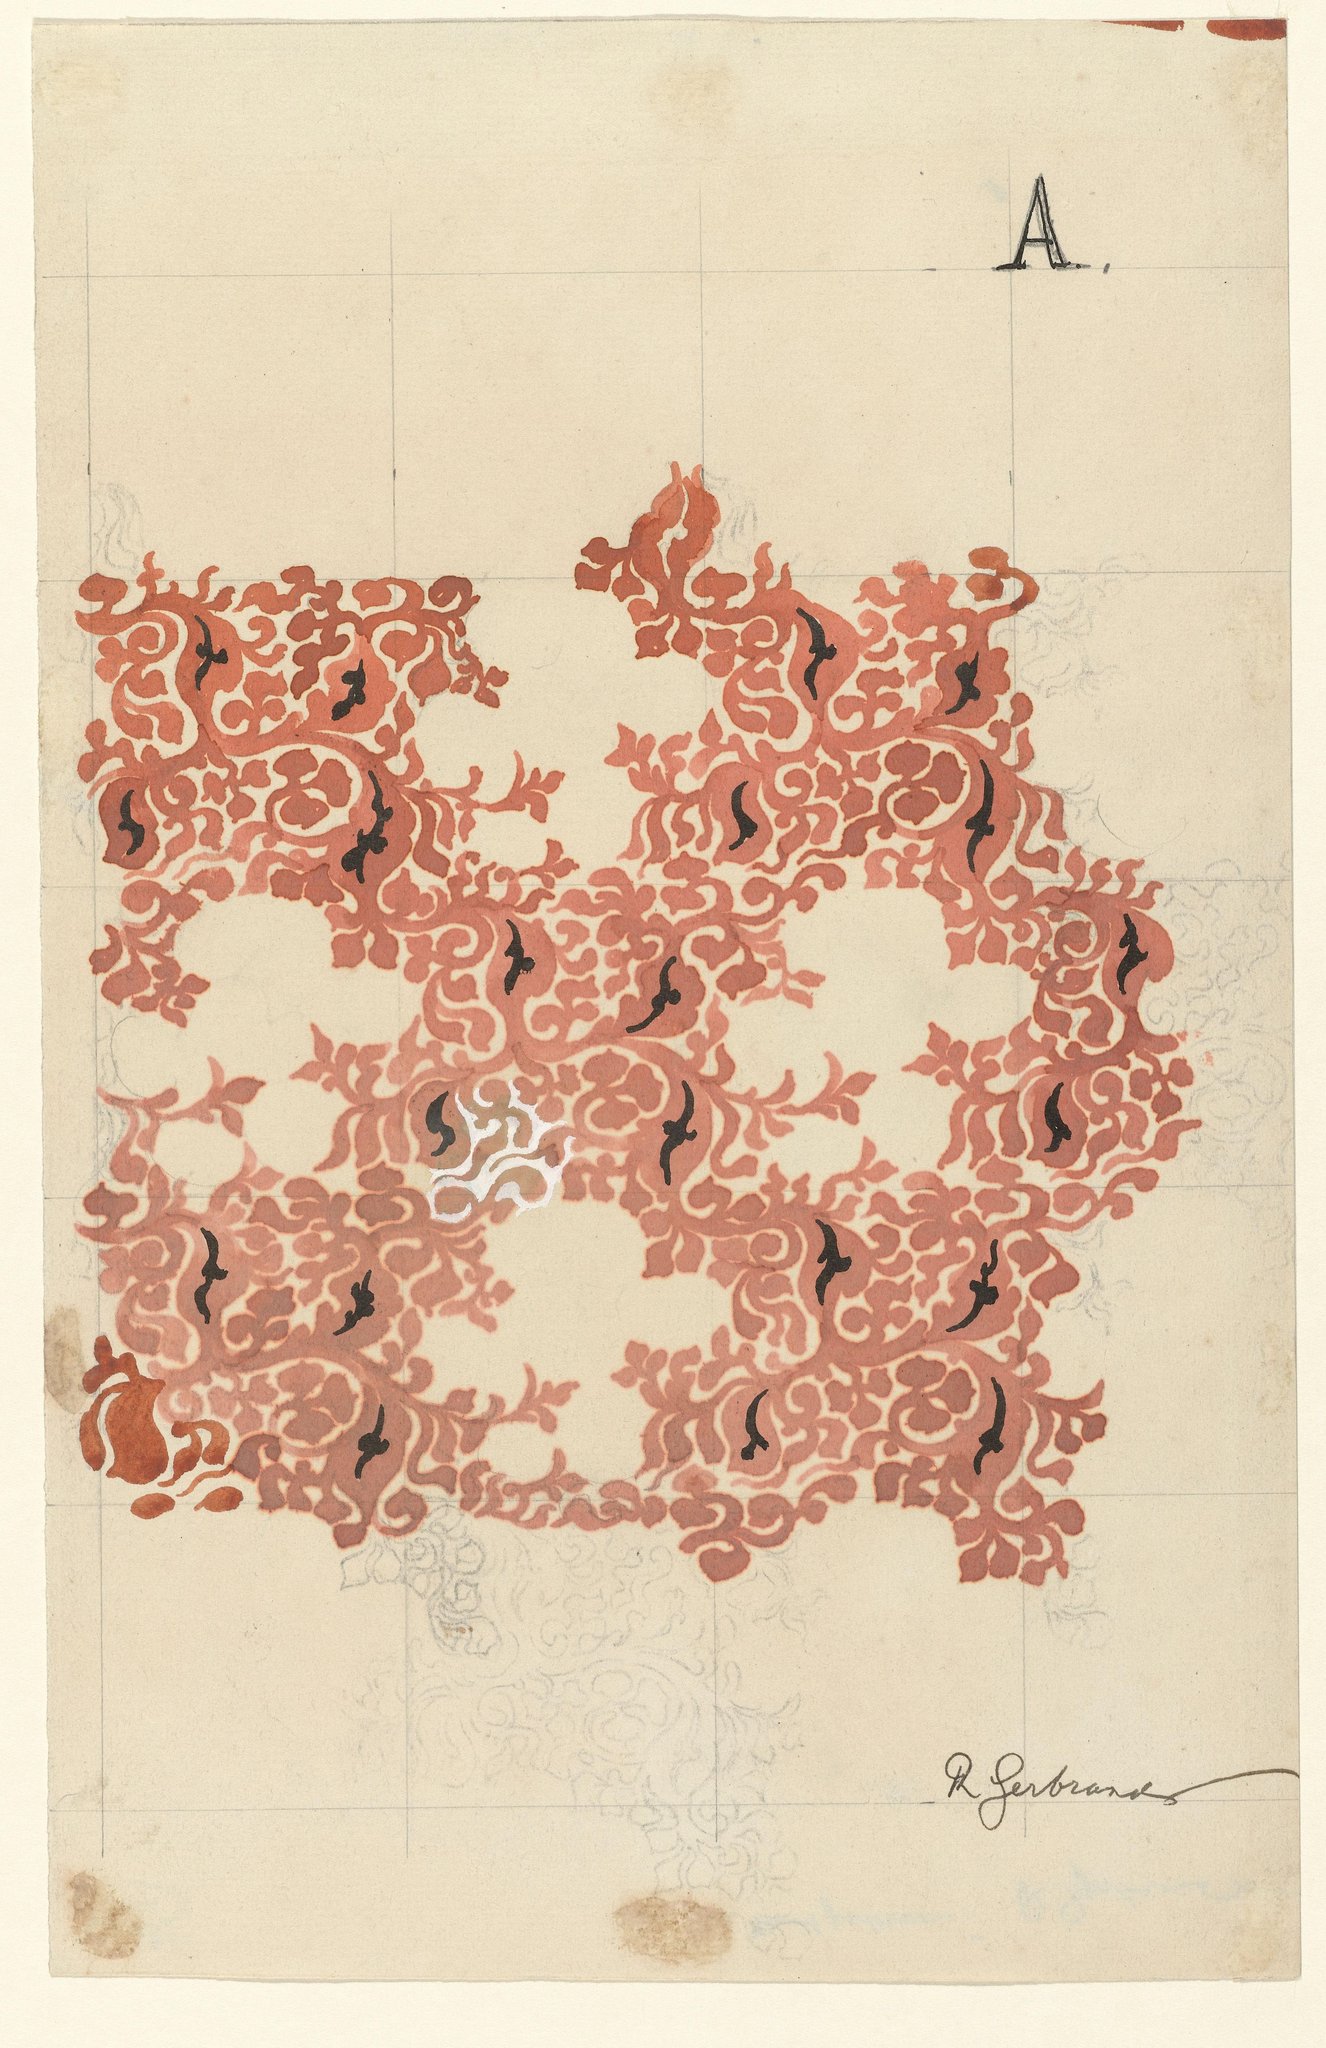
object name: drawing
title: Floraal decoratief ontwerp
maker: roelf gerbrands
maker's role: designer, draughtsman, print maker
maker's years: 1891-1954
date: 1901-1954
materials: paint, ink, paper, pencil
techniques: brush, pen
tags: foliage ~ ornament - aa - stylized